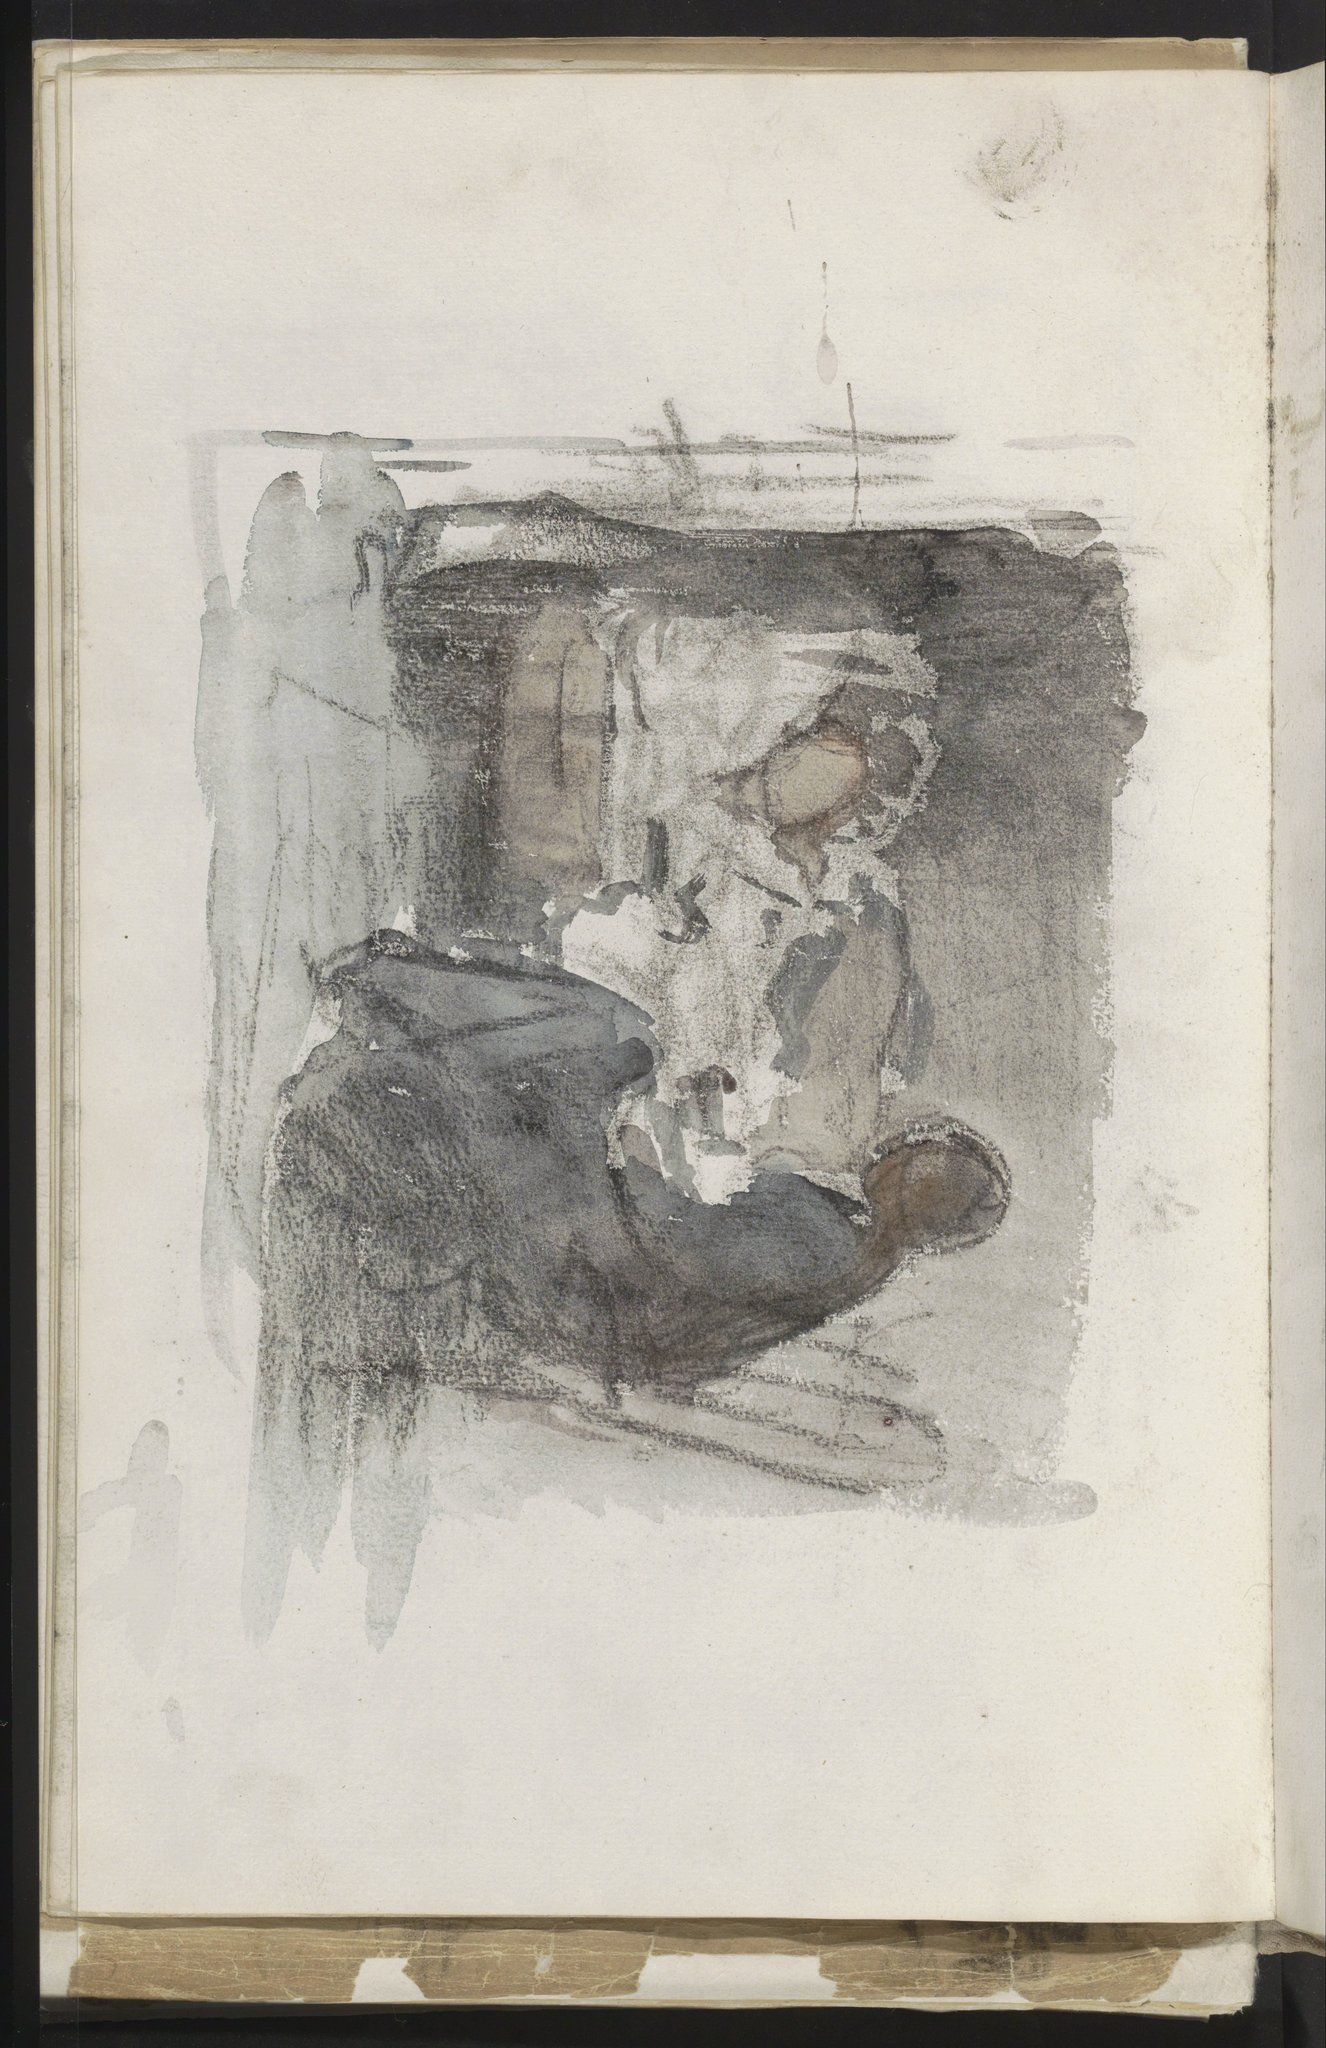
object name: sketchbook leaf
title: Moeder die aan het bed van een kind zit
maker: albert neuhuys (1844-1914)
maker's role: draughtsman, painter, print maker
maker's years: 1844-1914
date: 1854-1914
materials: chalk, paper, watercolor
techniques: brush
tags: sitting figure, child, interior of the house, bed, mother and child(ren), woman and child(ren) (family group)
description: Blad 34 verso uit een schetsboek met 53 bladen.